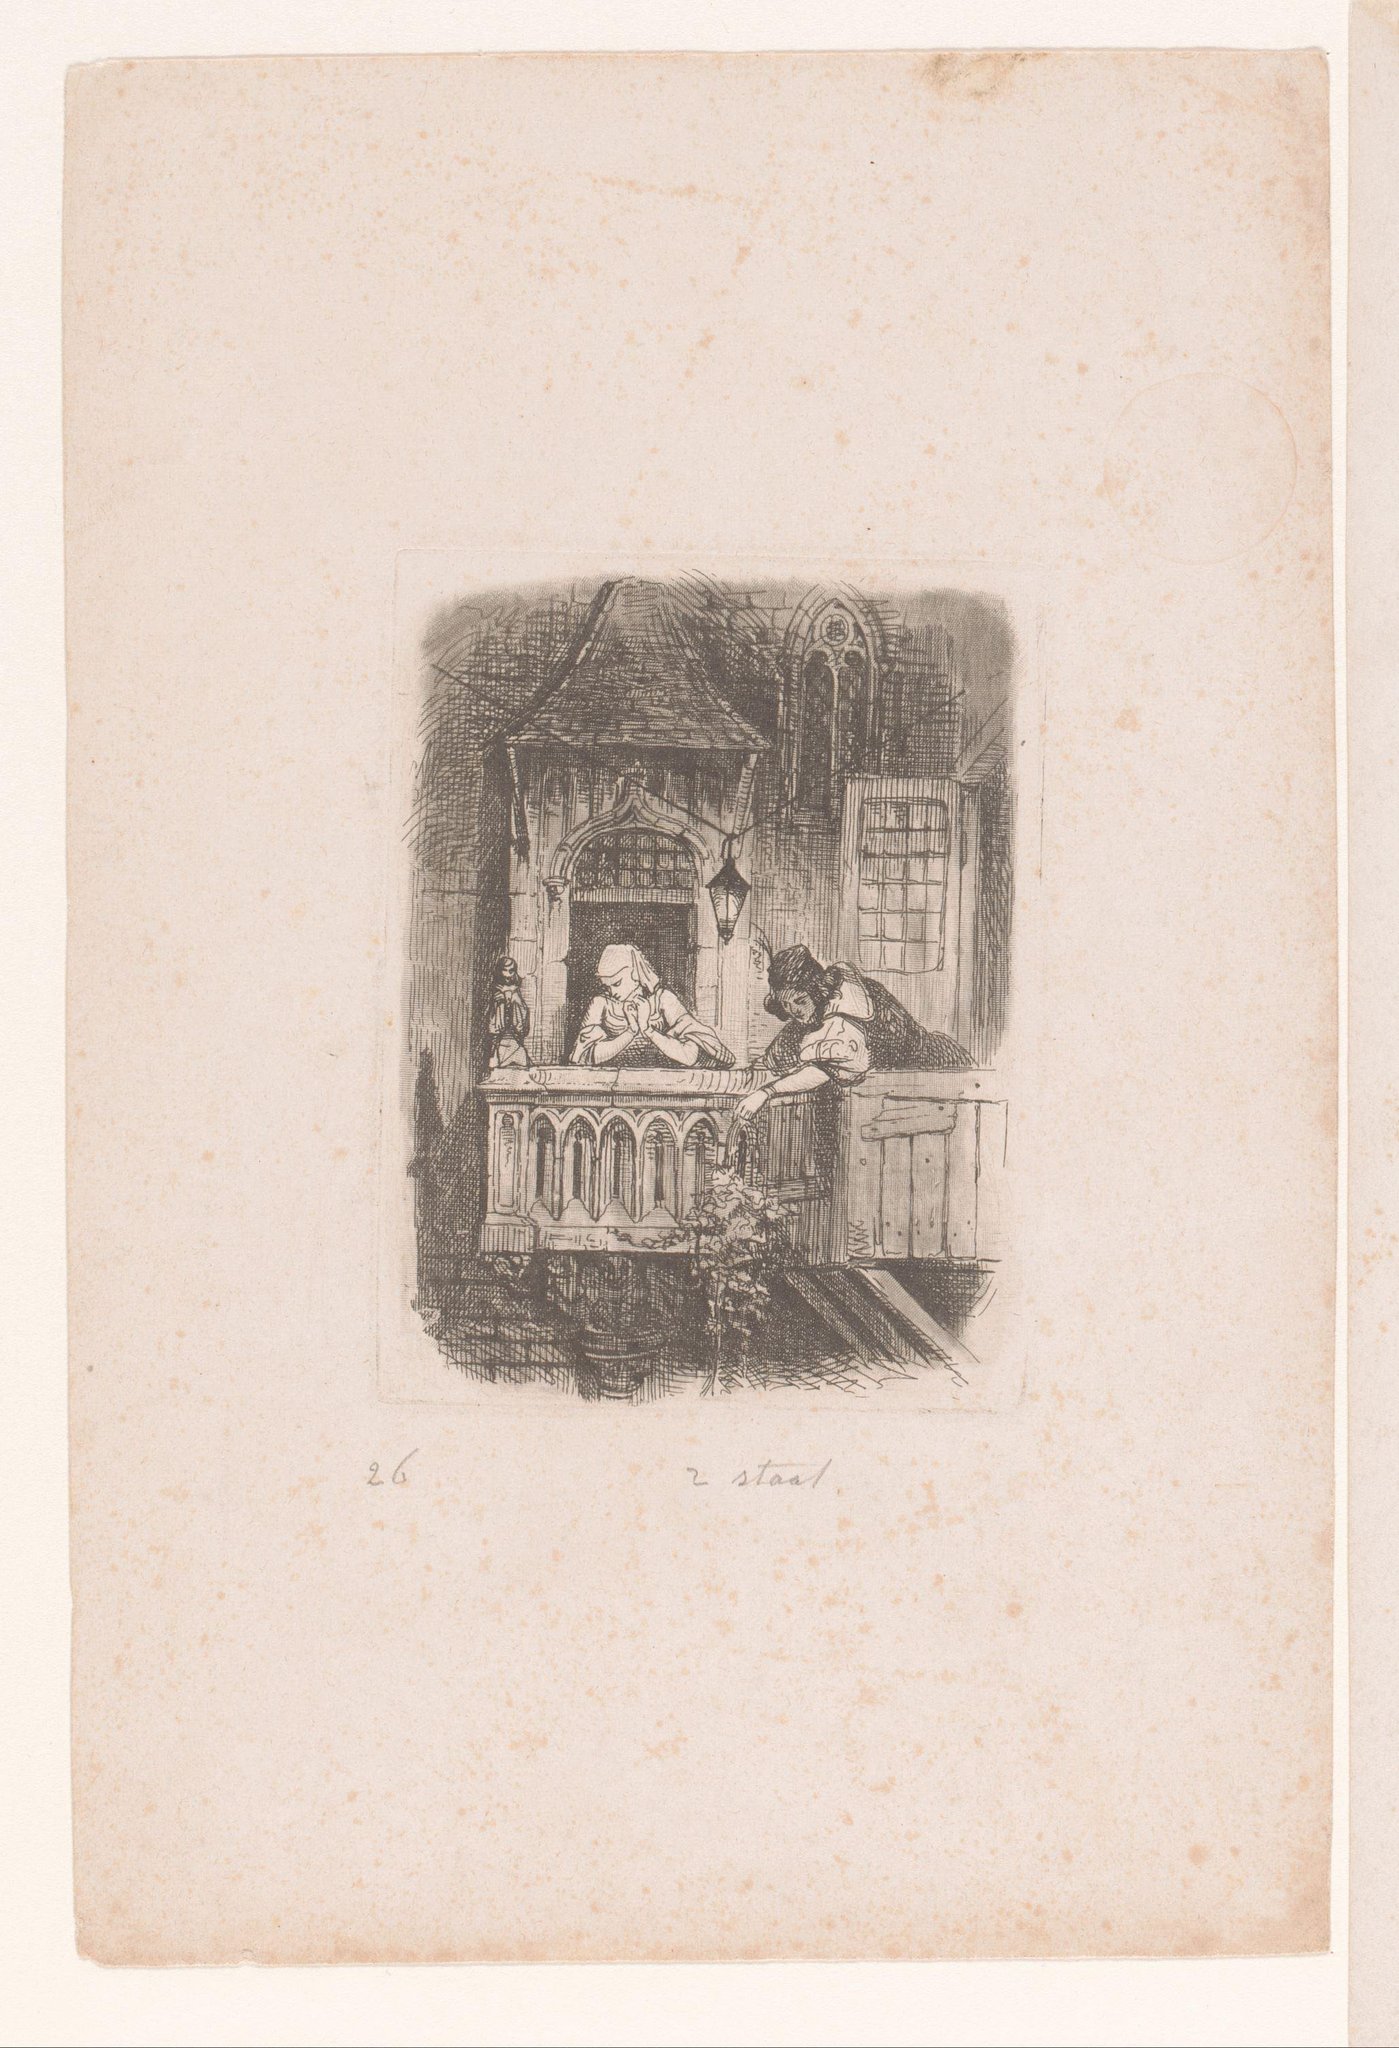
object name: print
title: Man en vrouw leunen over de rand van een balkon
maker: corneille seghers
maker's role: draughtsman, print maker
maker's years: 1814-1869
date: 1824-1869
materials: paper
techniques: drypoint, etching, roulette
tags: leaning forward, balcony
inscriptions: collector's mark: Lugt 2228